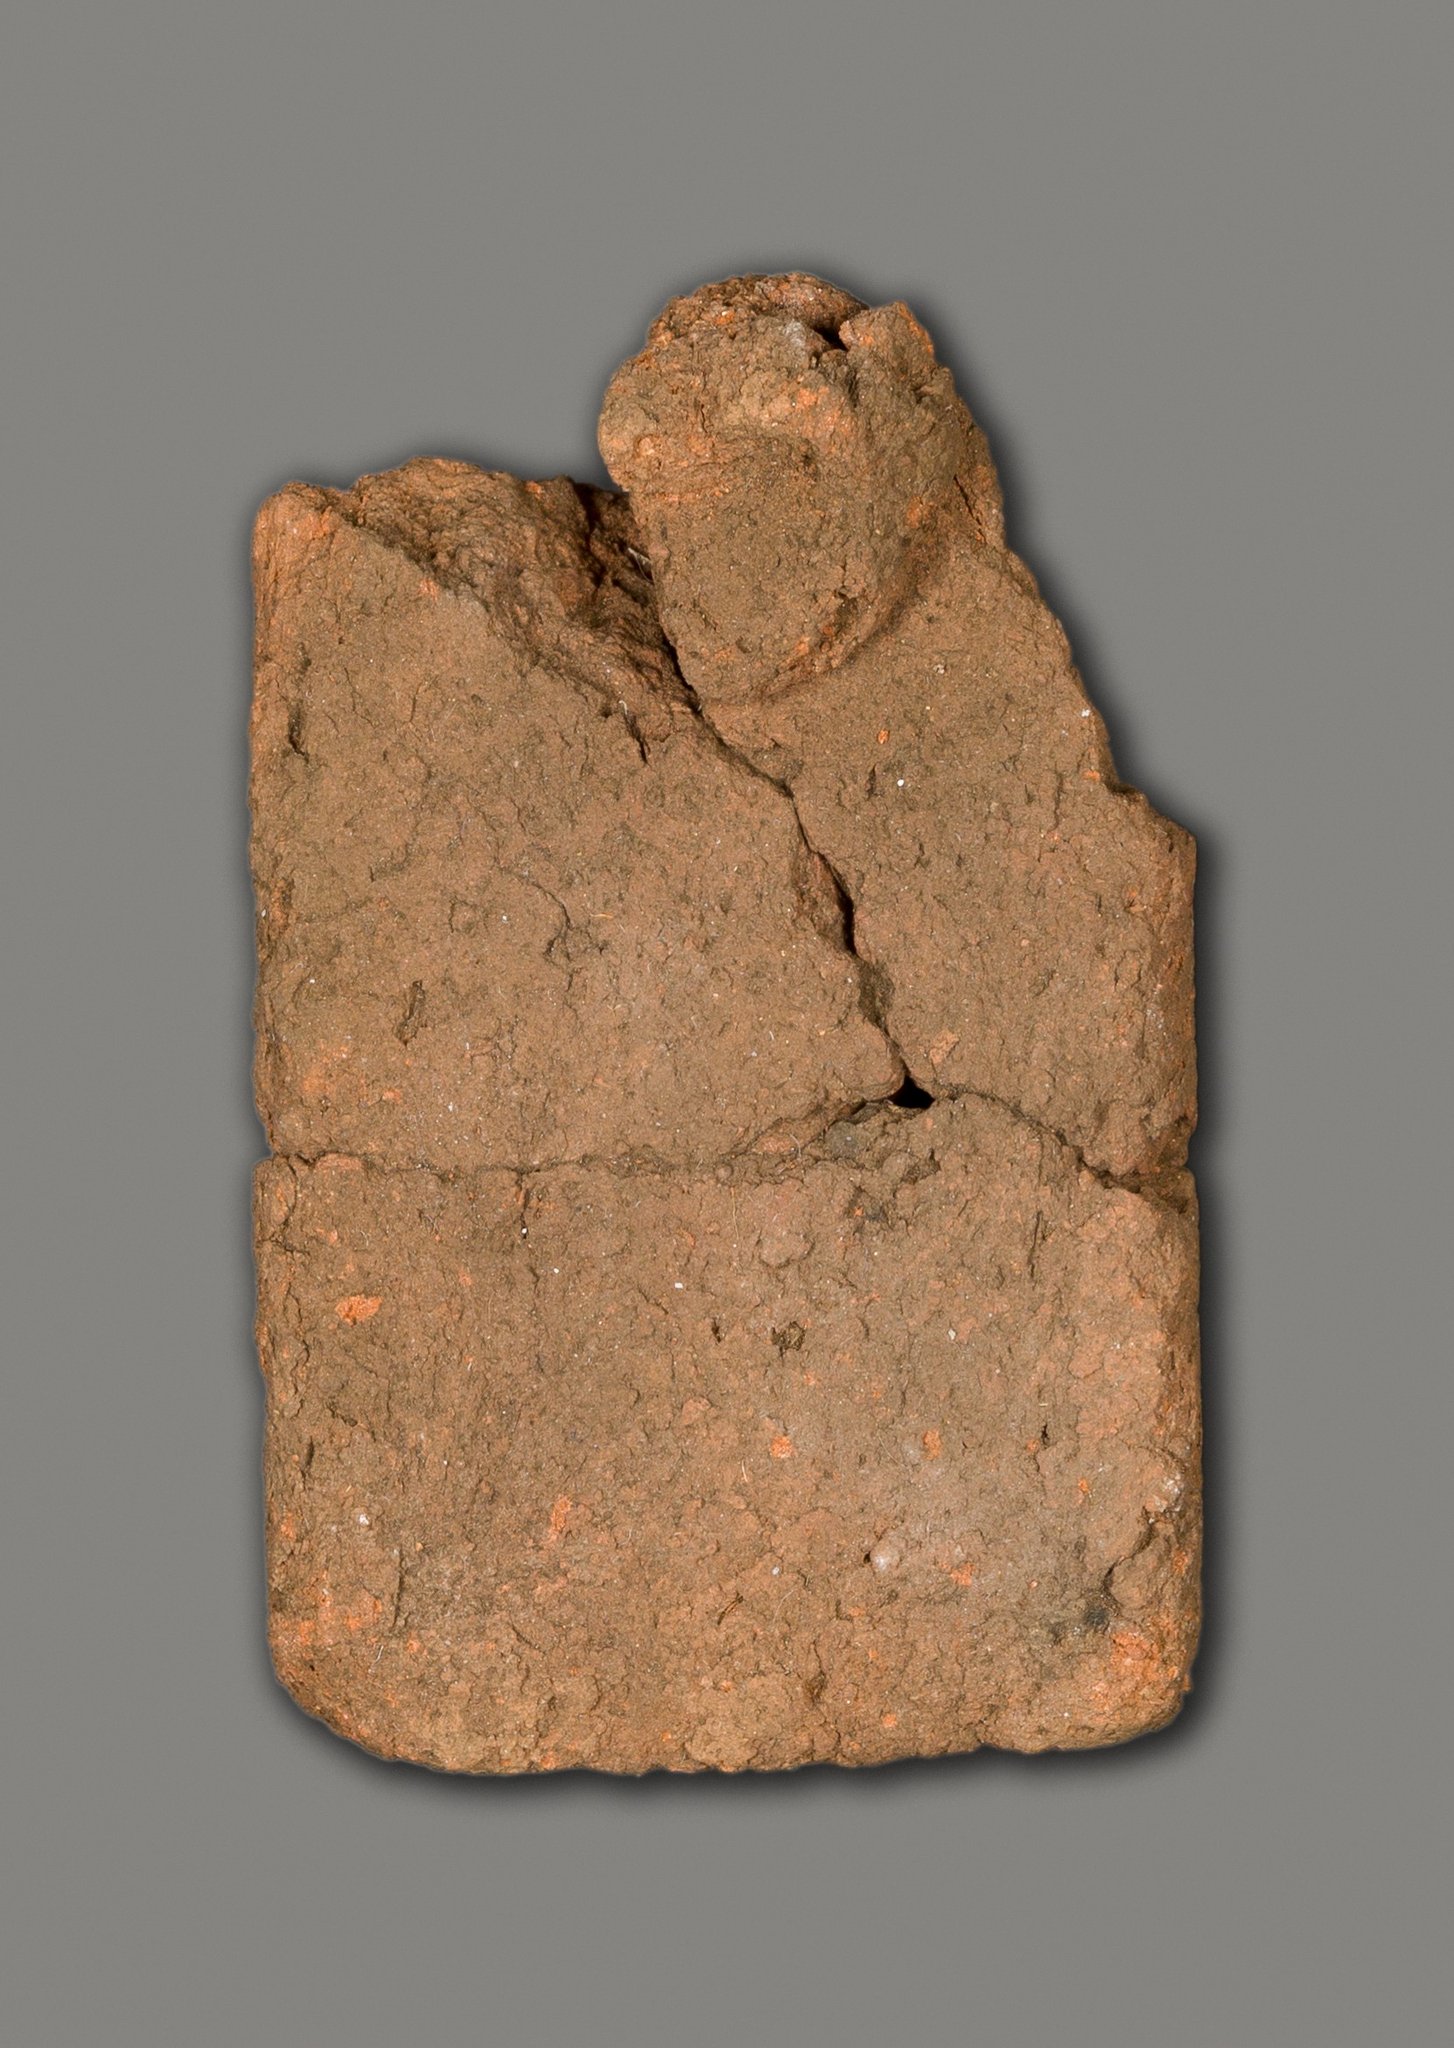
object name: figure, magical, execration, tablet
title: Magical Figure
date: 1802-1550 BCE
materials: clay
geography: egypt